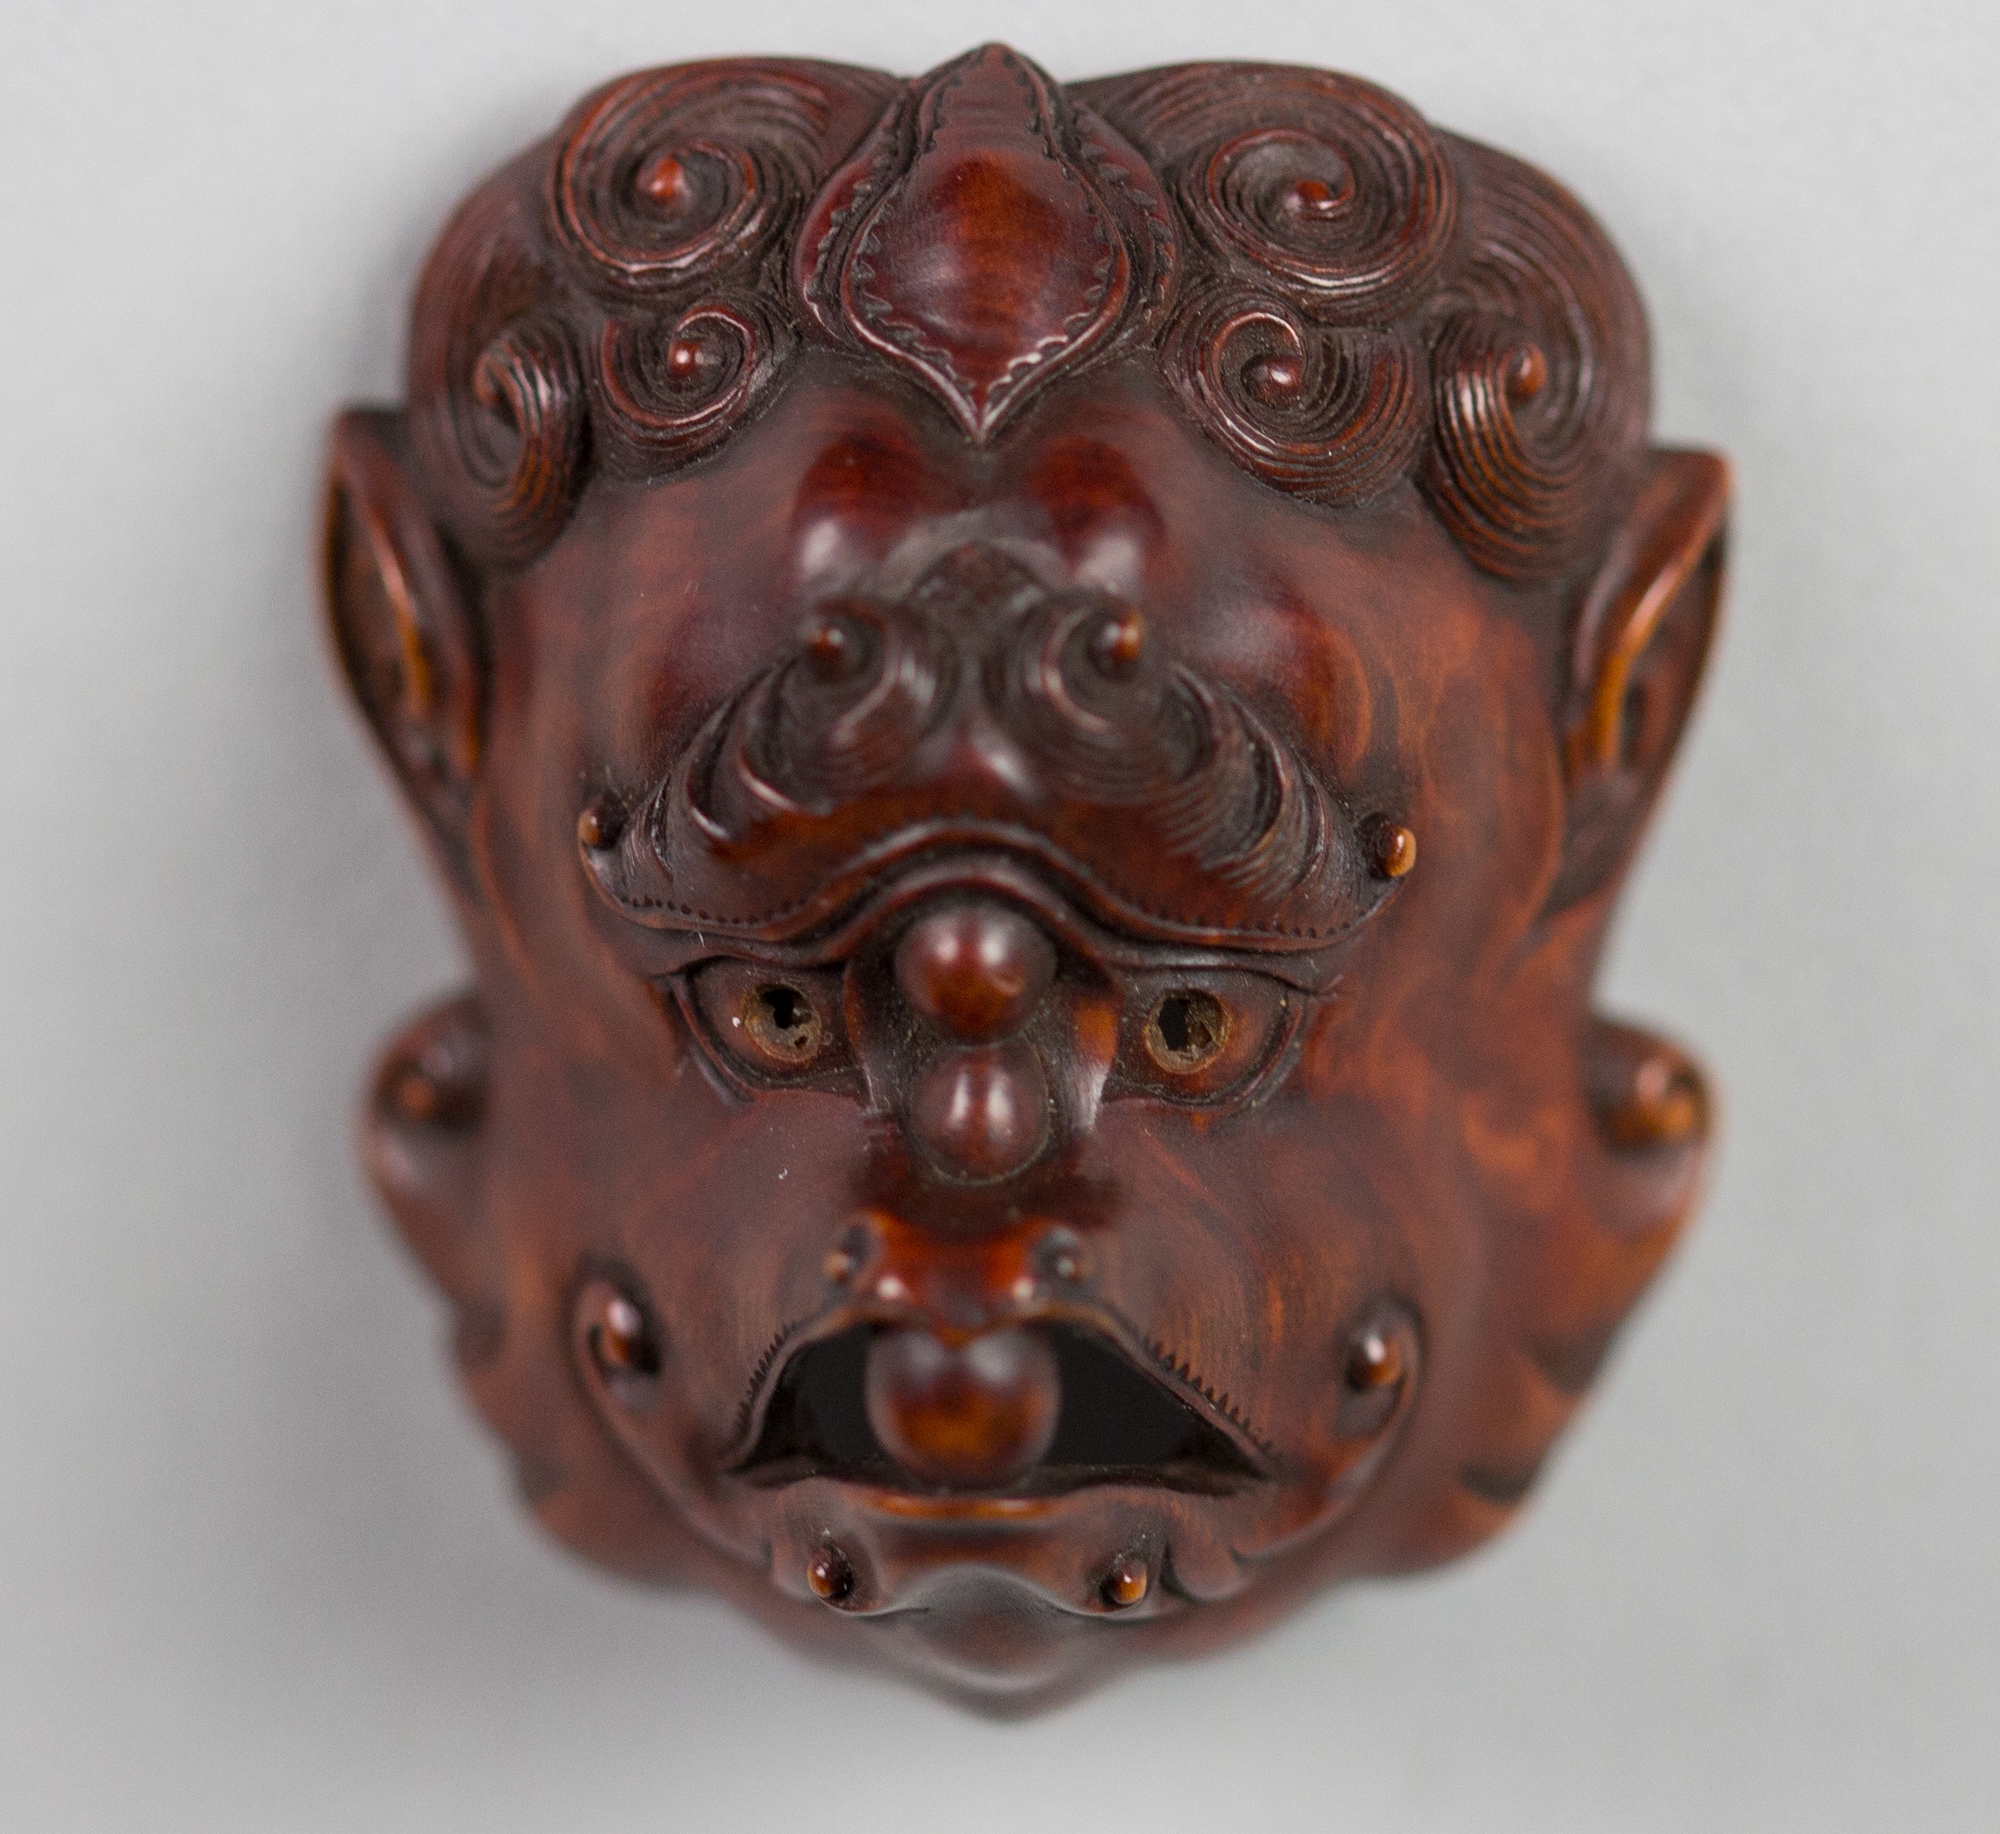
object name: netsuke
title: Garuda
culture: japanese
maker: tori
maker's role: artist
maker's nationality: japanese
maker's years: 1700-1799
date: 1701-1800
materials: wood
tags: mythical creatures